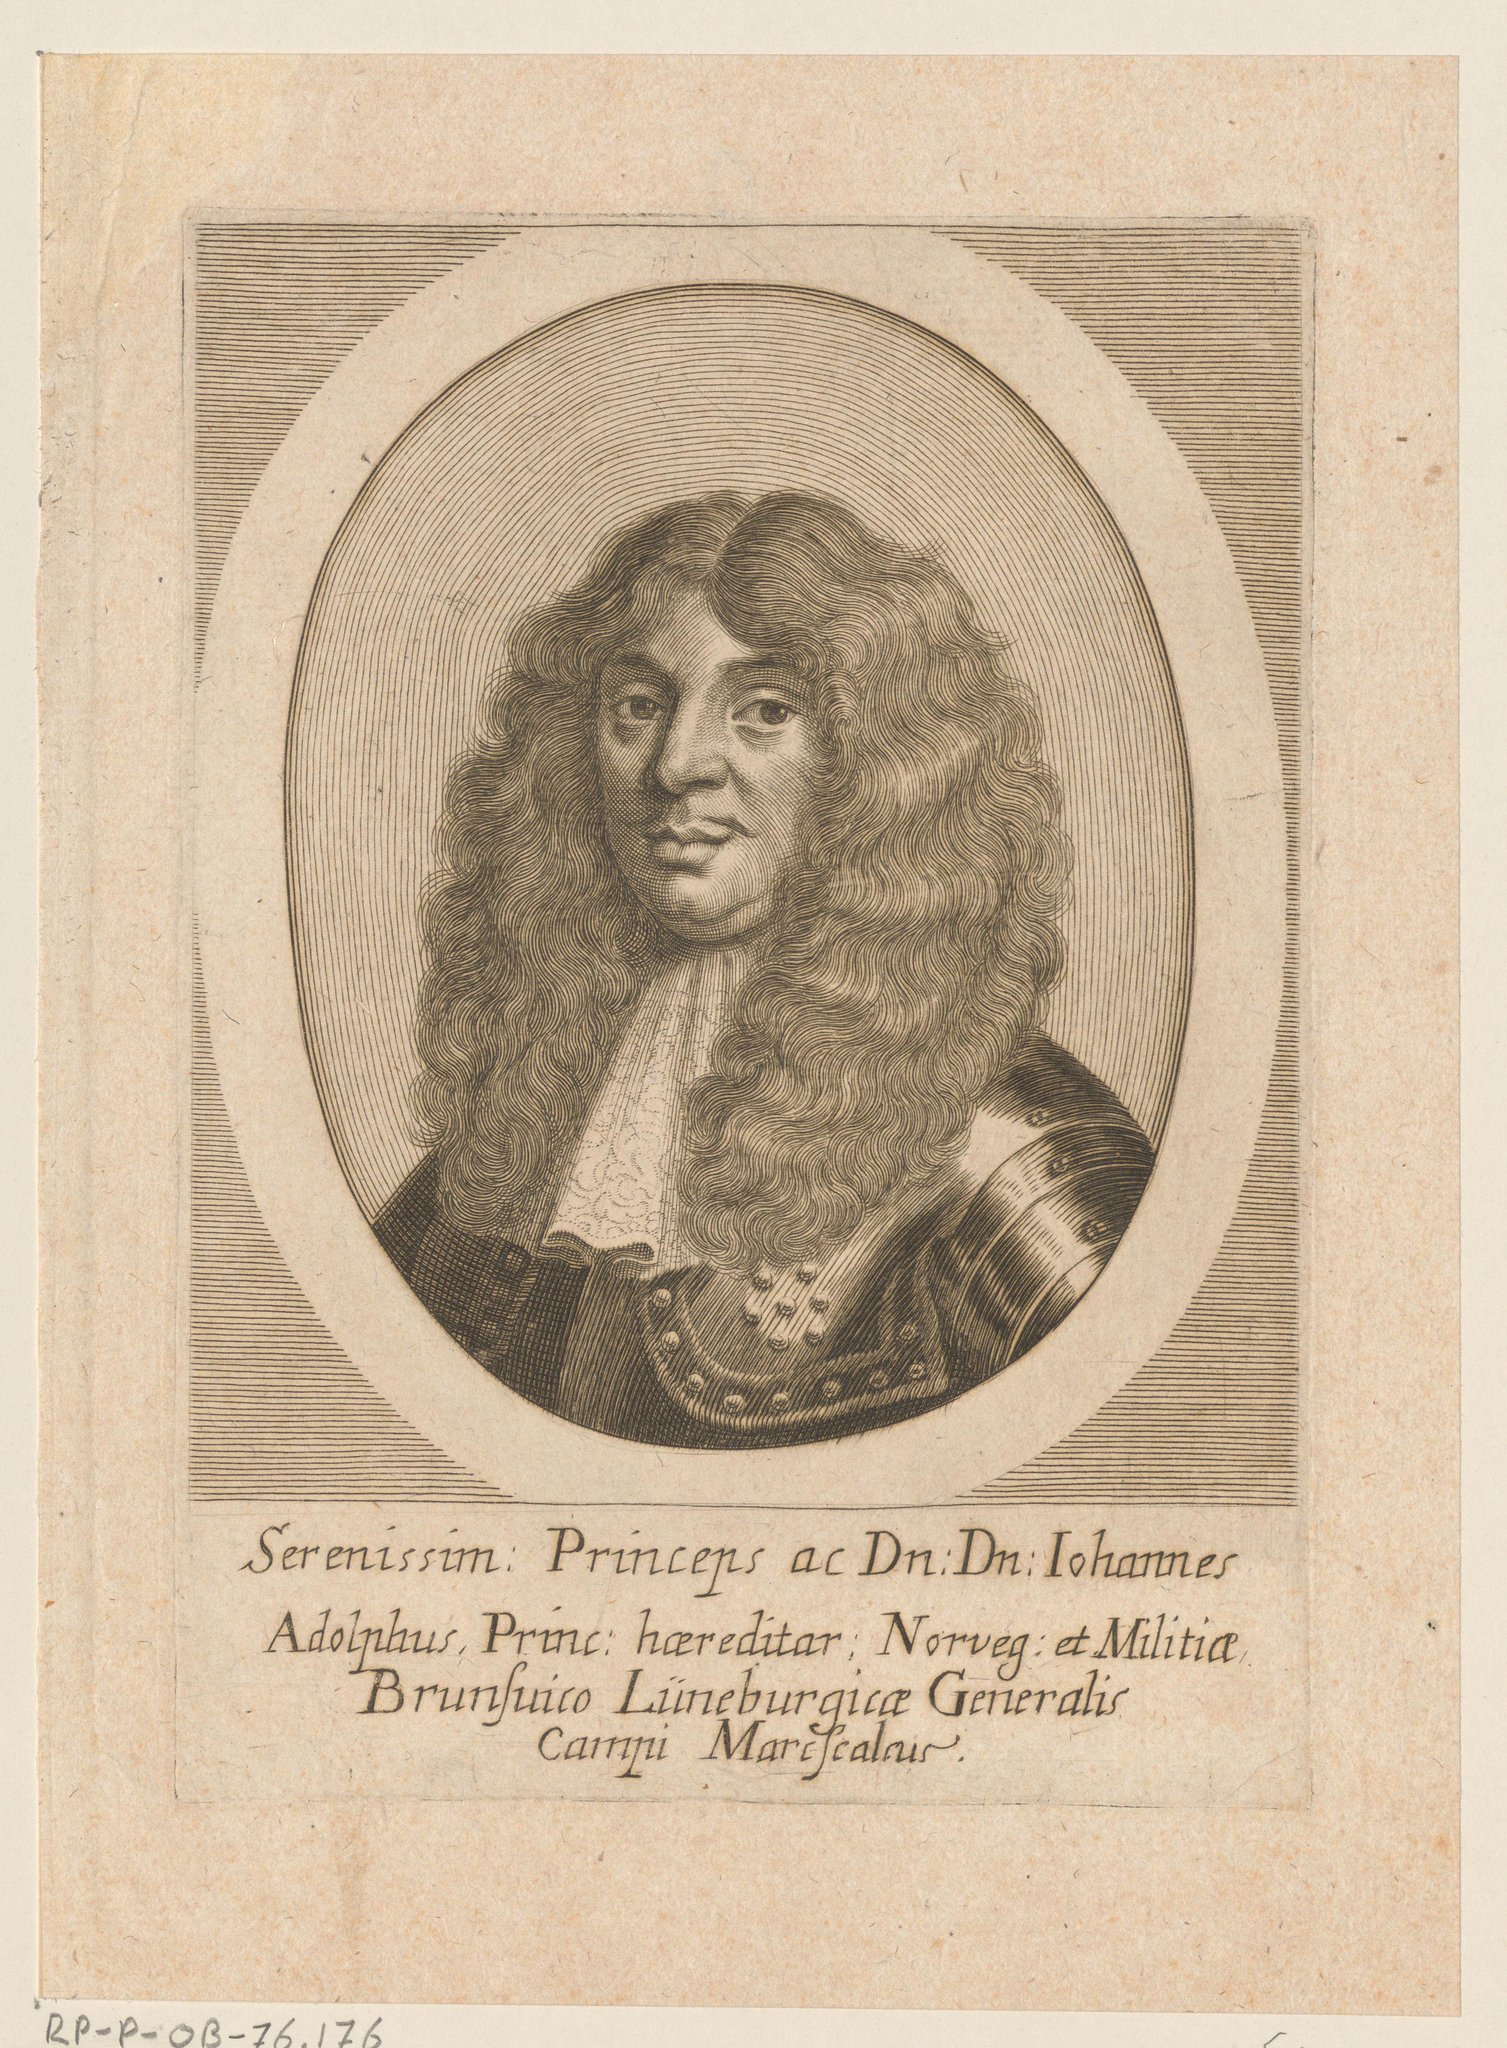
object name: print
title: Portret van Johan Adolf, hertog van Sleeswijk Holstein Sondersburg Plön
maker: Anonymous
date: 1682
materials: paper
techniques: engraving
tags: historical persons, officer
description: Prent mogelijk uit: Theatrum Europaeum (...). Frankfurt: erven Matthaus Merian, 1682, dl. 11. Prent mogelijk ook uit latere publicaties.